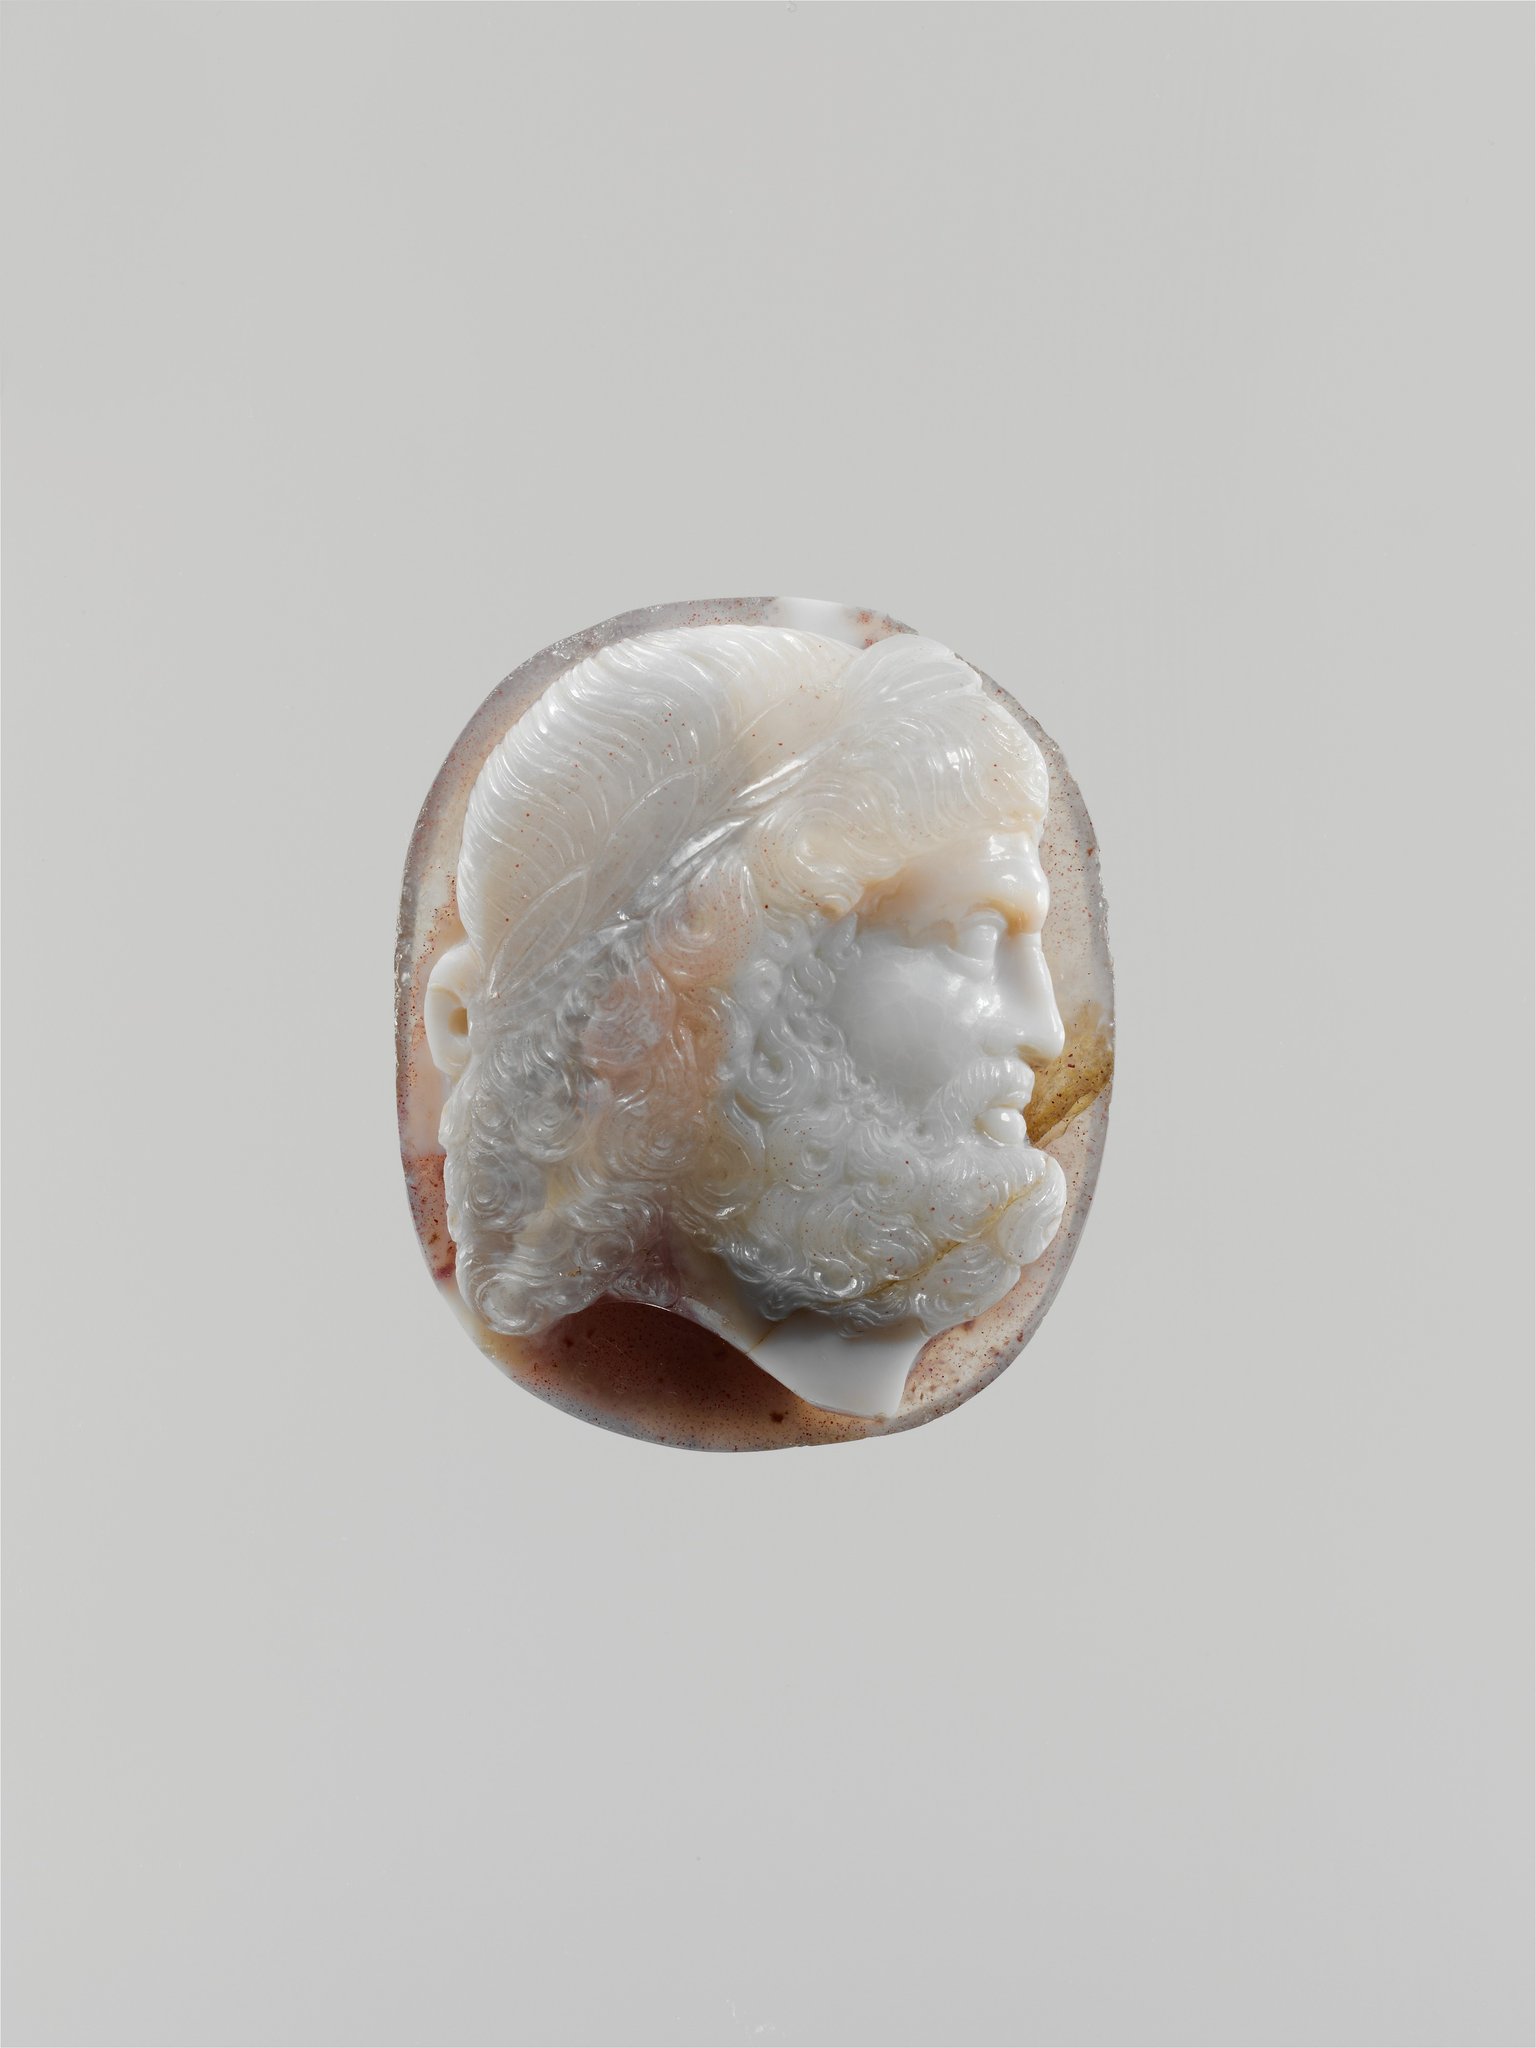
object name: cameo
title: Head of Jupiter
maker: filippo rega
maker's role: artist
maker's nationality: italian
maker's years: 1761-1861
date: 1801-1833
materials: onyx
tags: jupiter